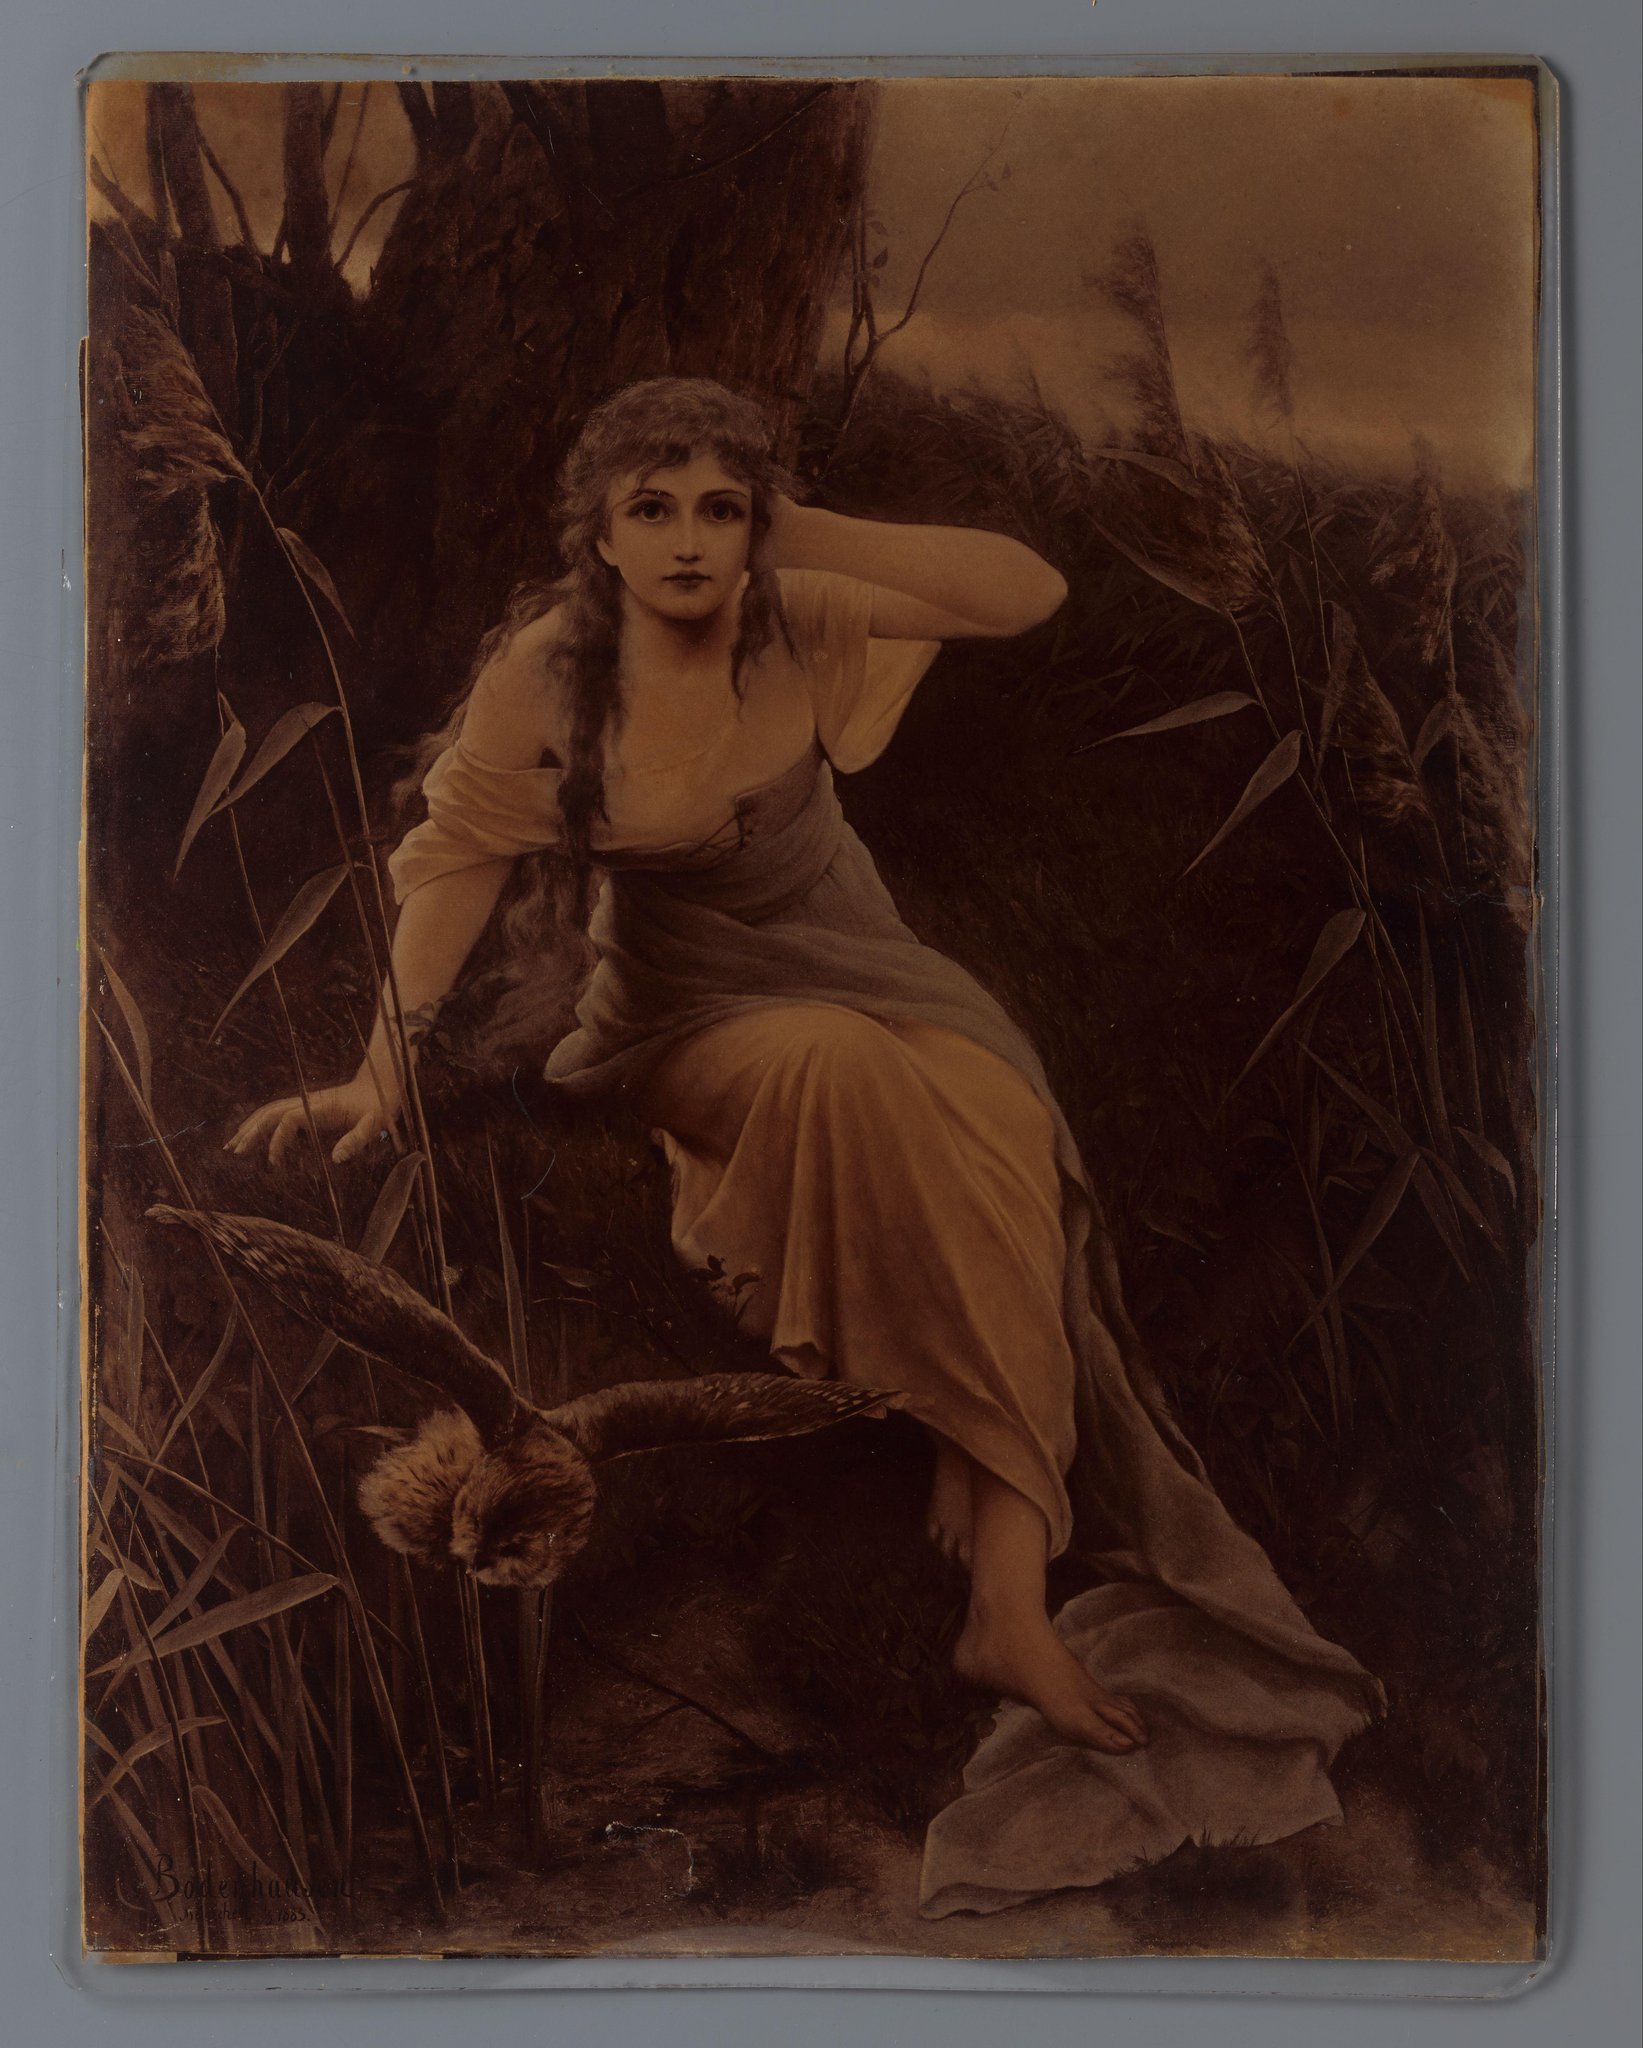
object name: reproduction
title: Fotoreproductie van een schilderij van een jonge vrouw met uil naar Cuno von Bodenhausen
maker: Anonymous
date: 1883-1900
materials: paint, glass, photographic support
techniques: albumen print, hand coloring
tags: historical persons - bb - woman, owls